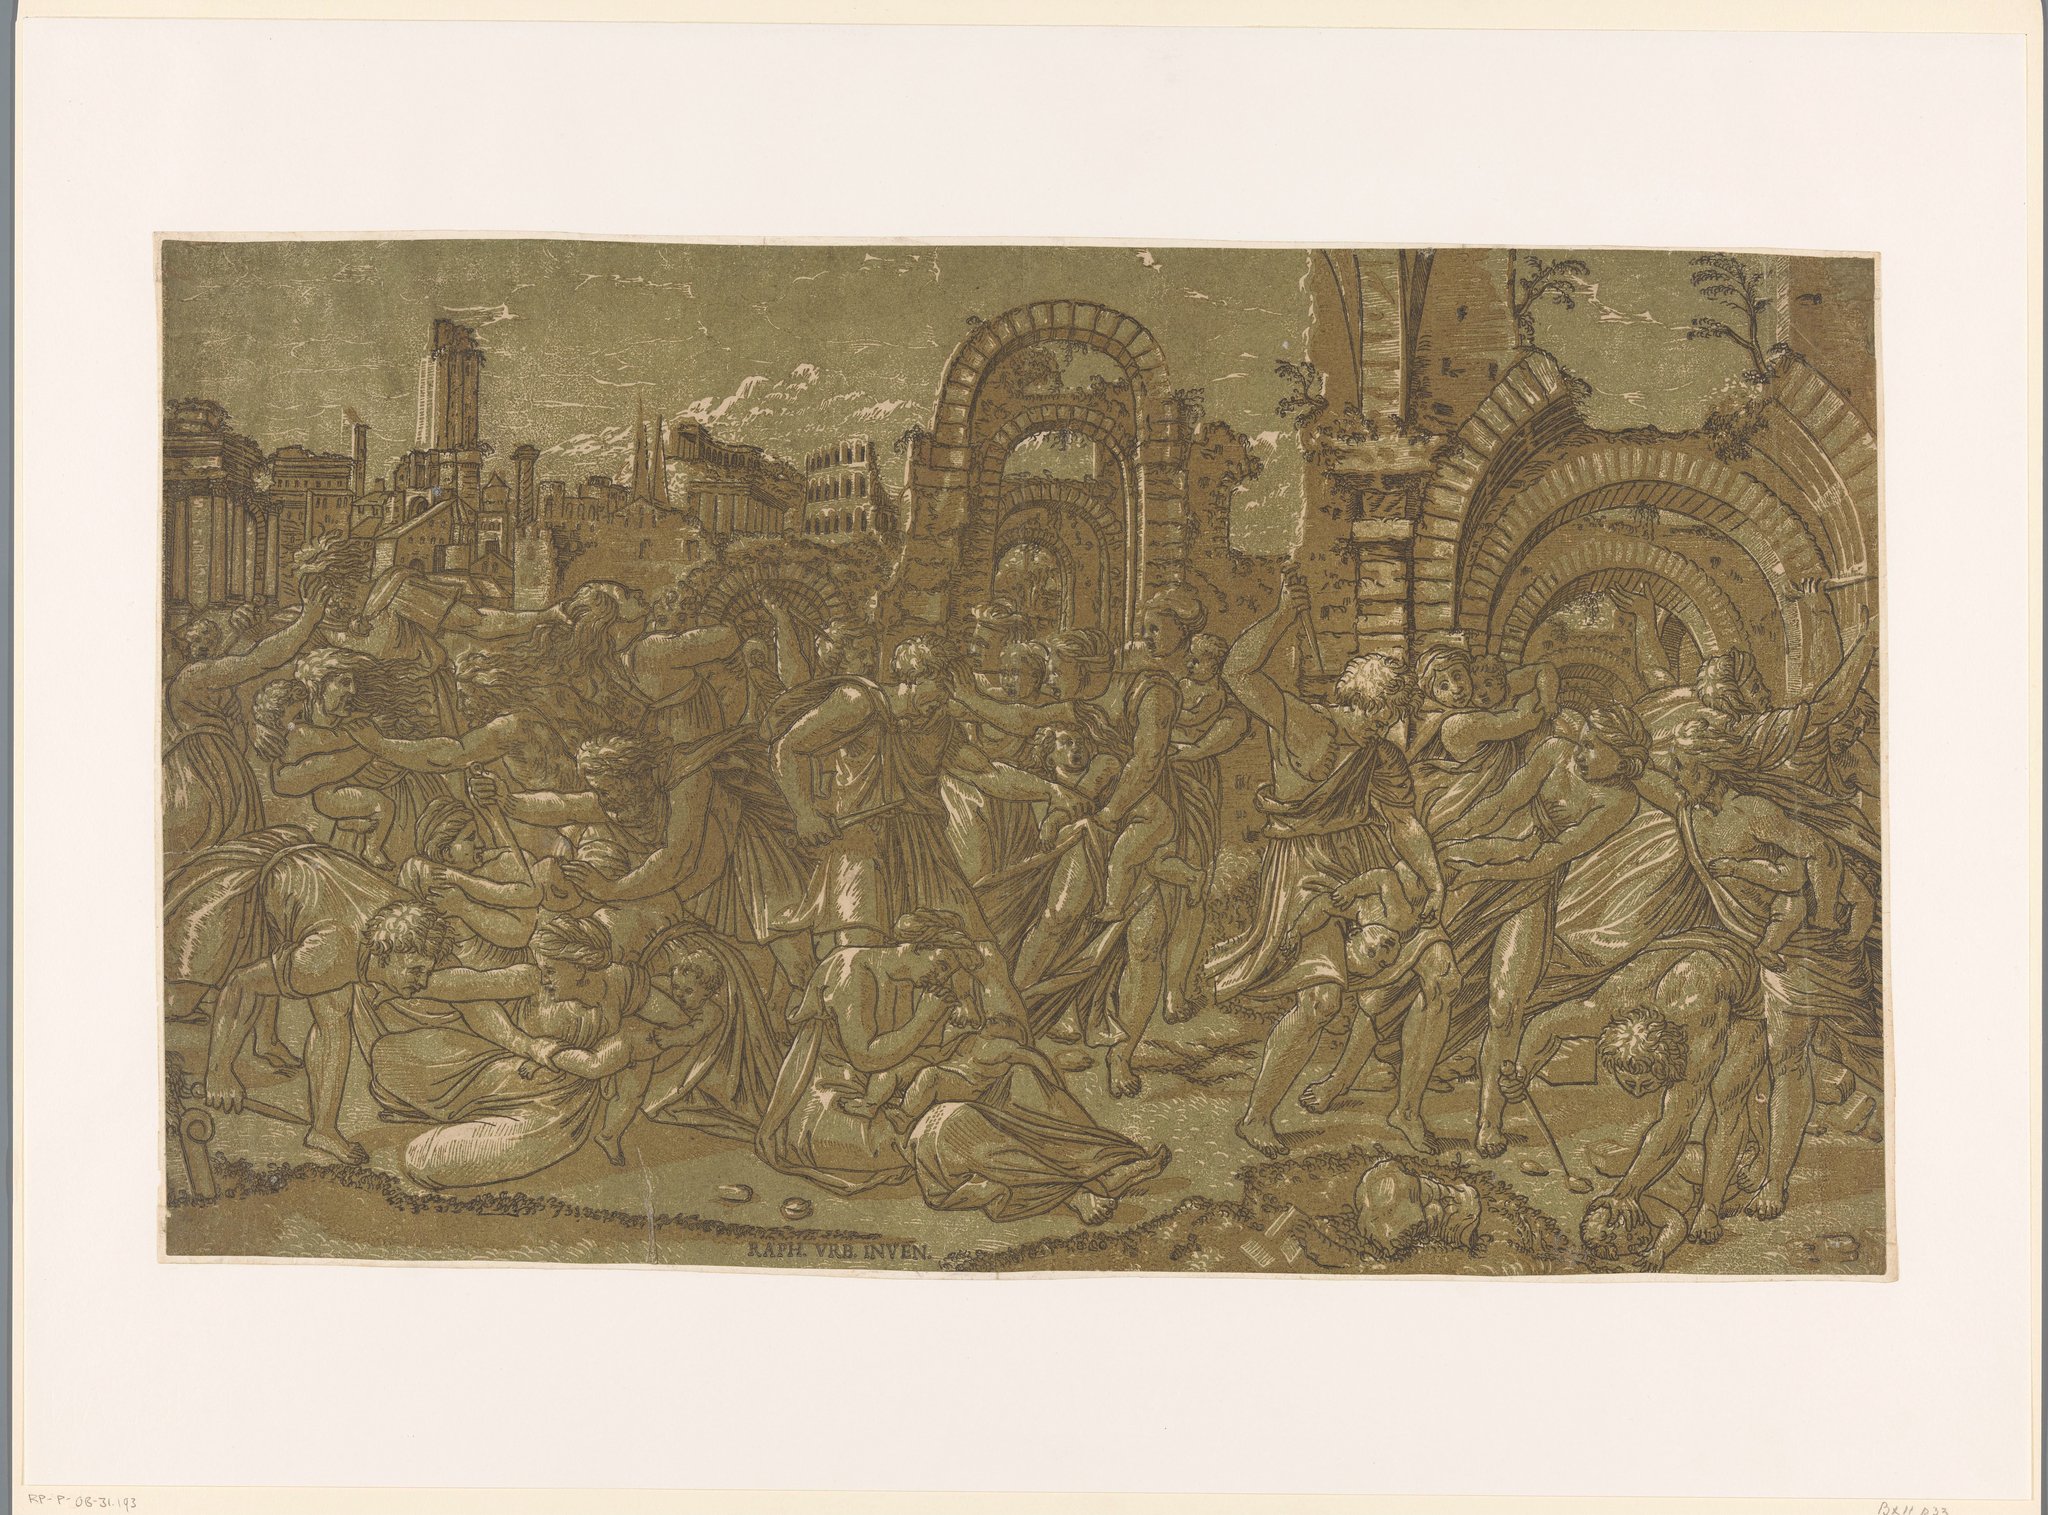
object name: print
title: Kindermoord te Betlehem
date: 1544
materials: paper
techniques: woodcut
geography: italy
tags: the massacre ot the innocents; sometimes herod looking on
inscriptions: collector's mark: Lugt 240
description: Wanhopige moeders proberen hun kinderen te beschermen tegen de soldaten van Herodes. Op de voorgrond een vrouwen treurend bij het dode lichamen van haar kind.